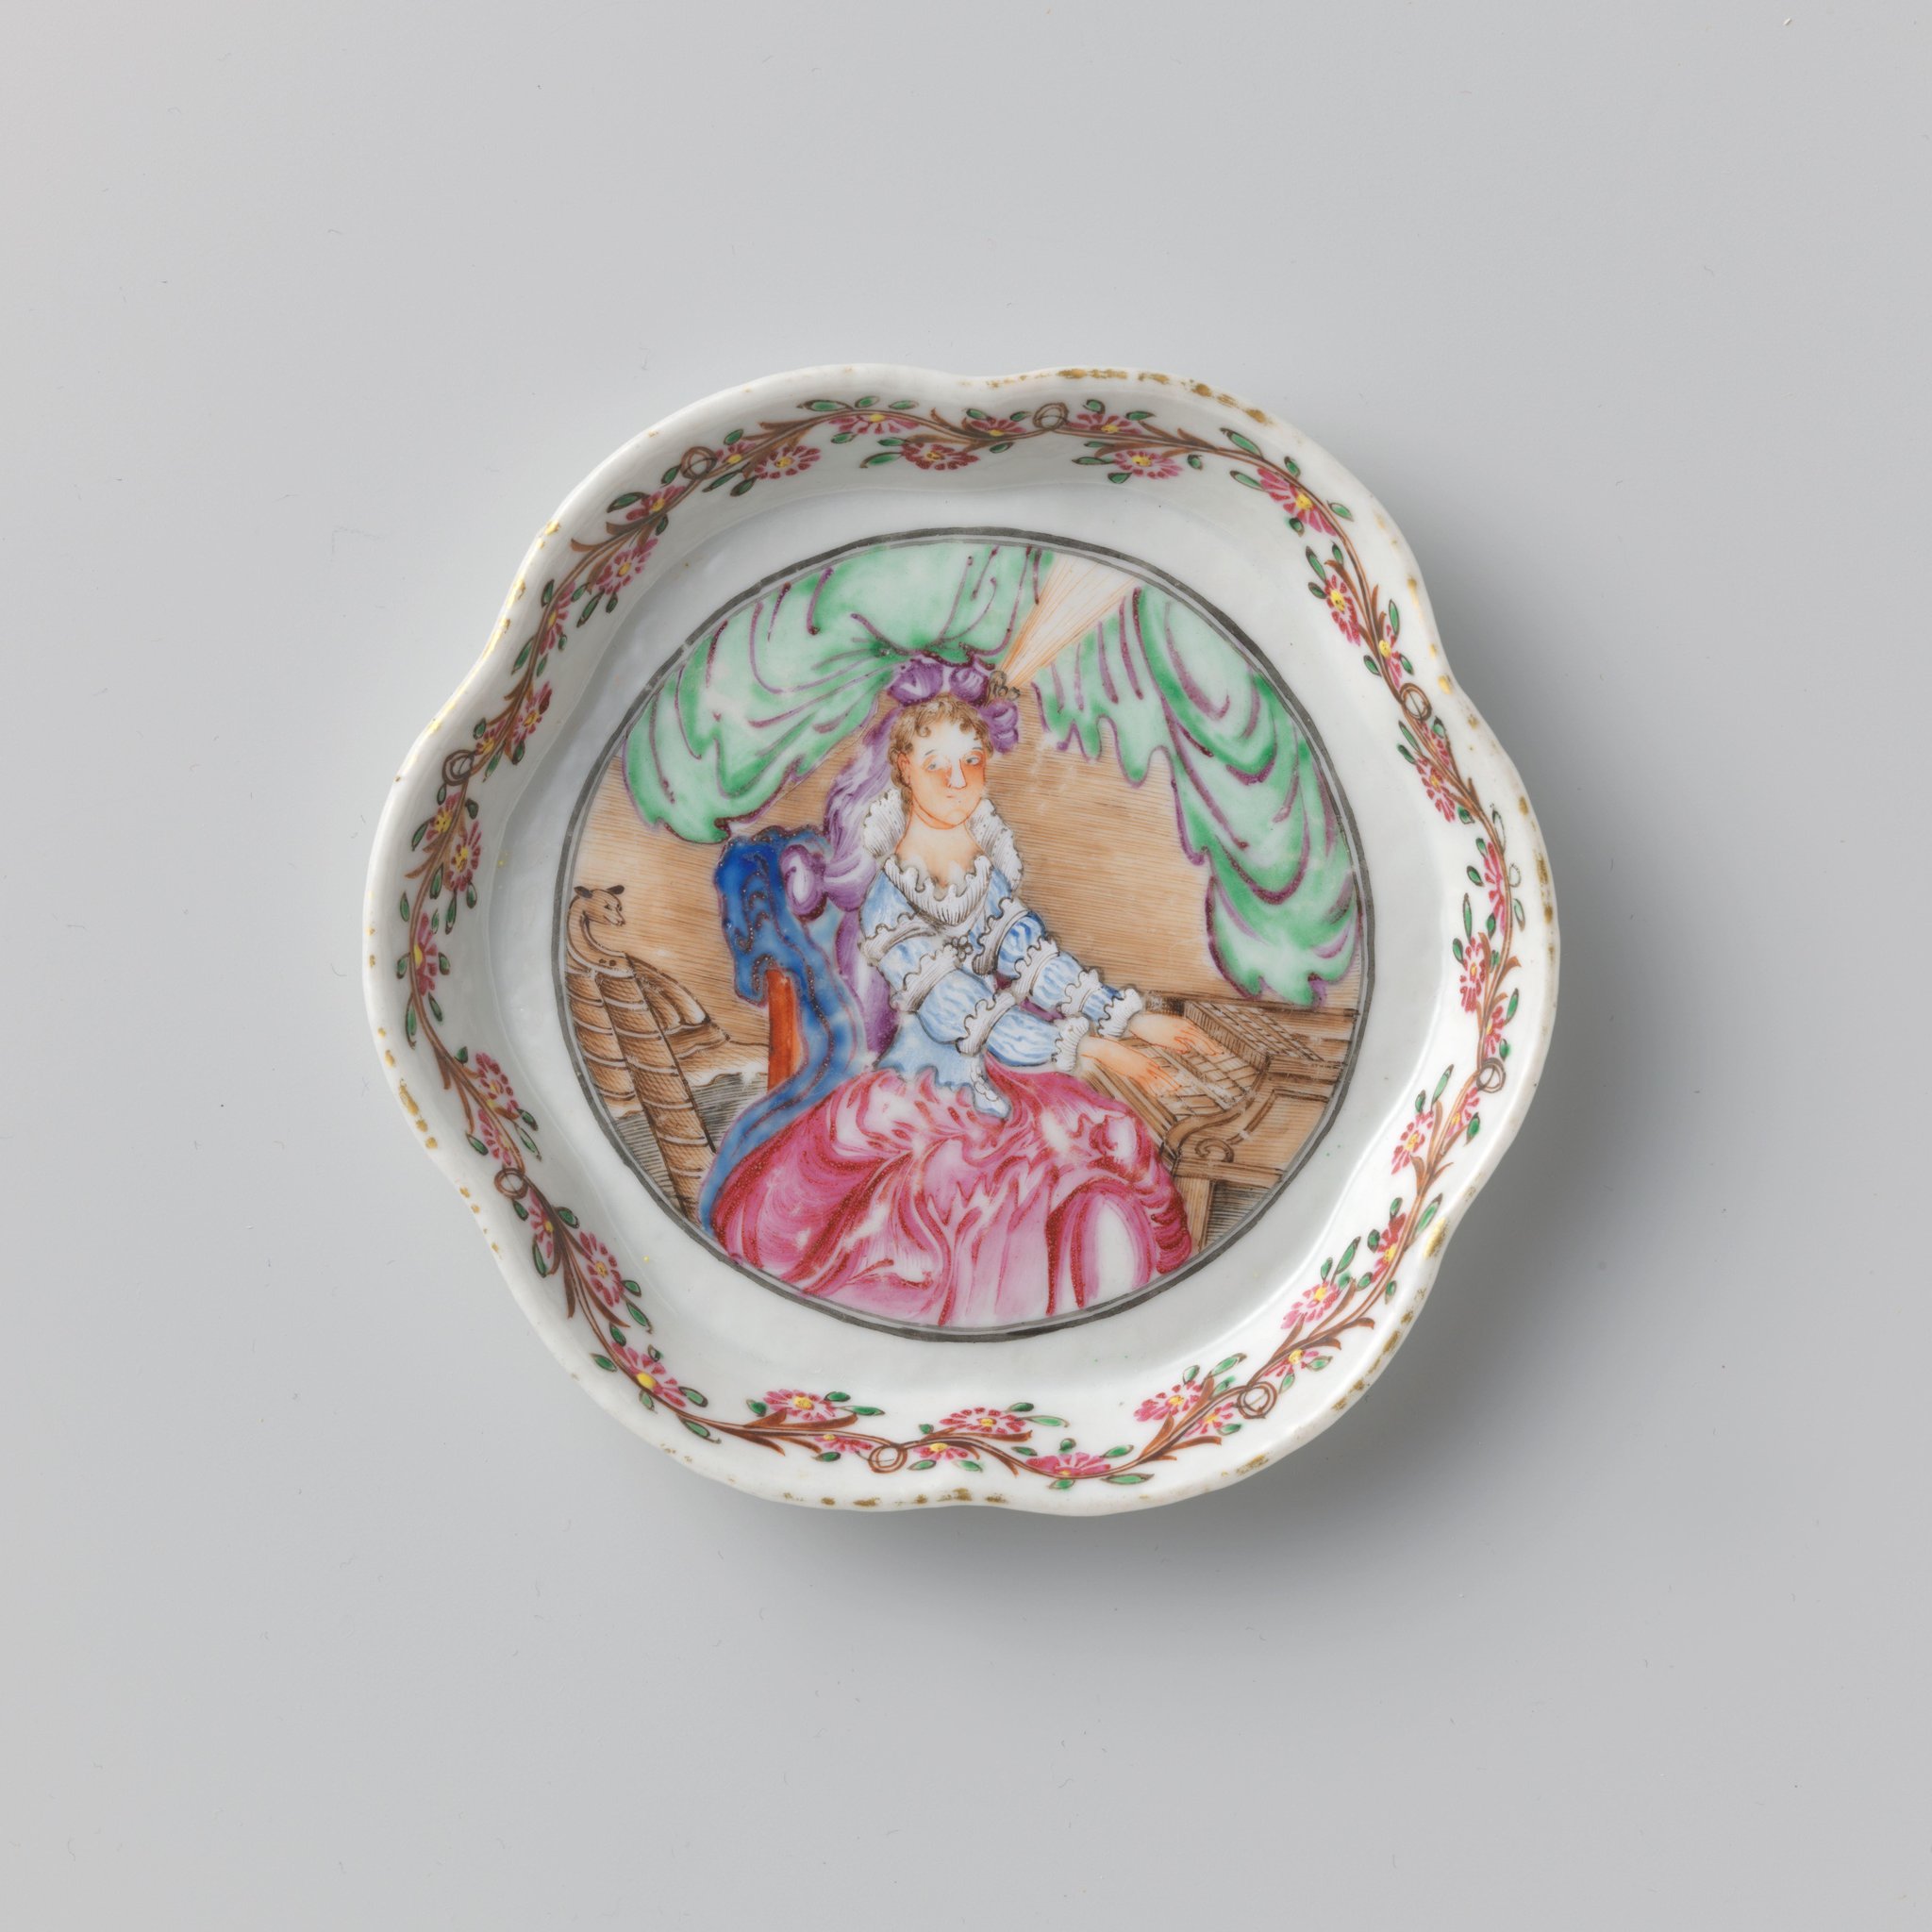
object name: pattipan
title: Six-lobed teapot stand with an woman playing a piano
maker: Anonymous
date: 1760-1780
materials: glaze, gold, paint, porcelain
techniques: firing, forming, gilding, turning, vitrification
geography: china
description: Pattipan van porselein met een zesmaal gelobde wand, beschilderd op het glazuur in blauw, rood, roze, groen, geel, paars, bruin, zwart en goud. Op het plat een vrouw in een interieur spelend op een klavier; de binnenrand met een band bloemranken. Onderzijde ongeglazuurd. Europese vorm en voorstelling in emailkleuren.